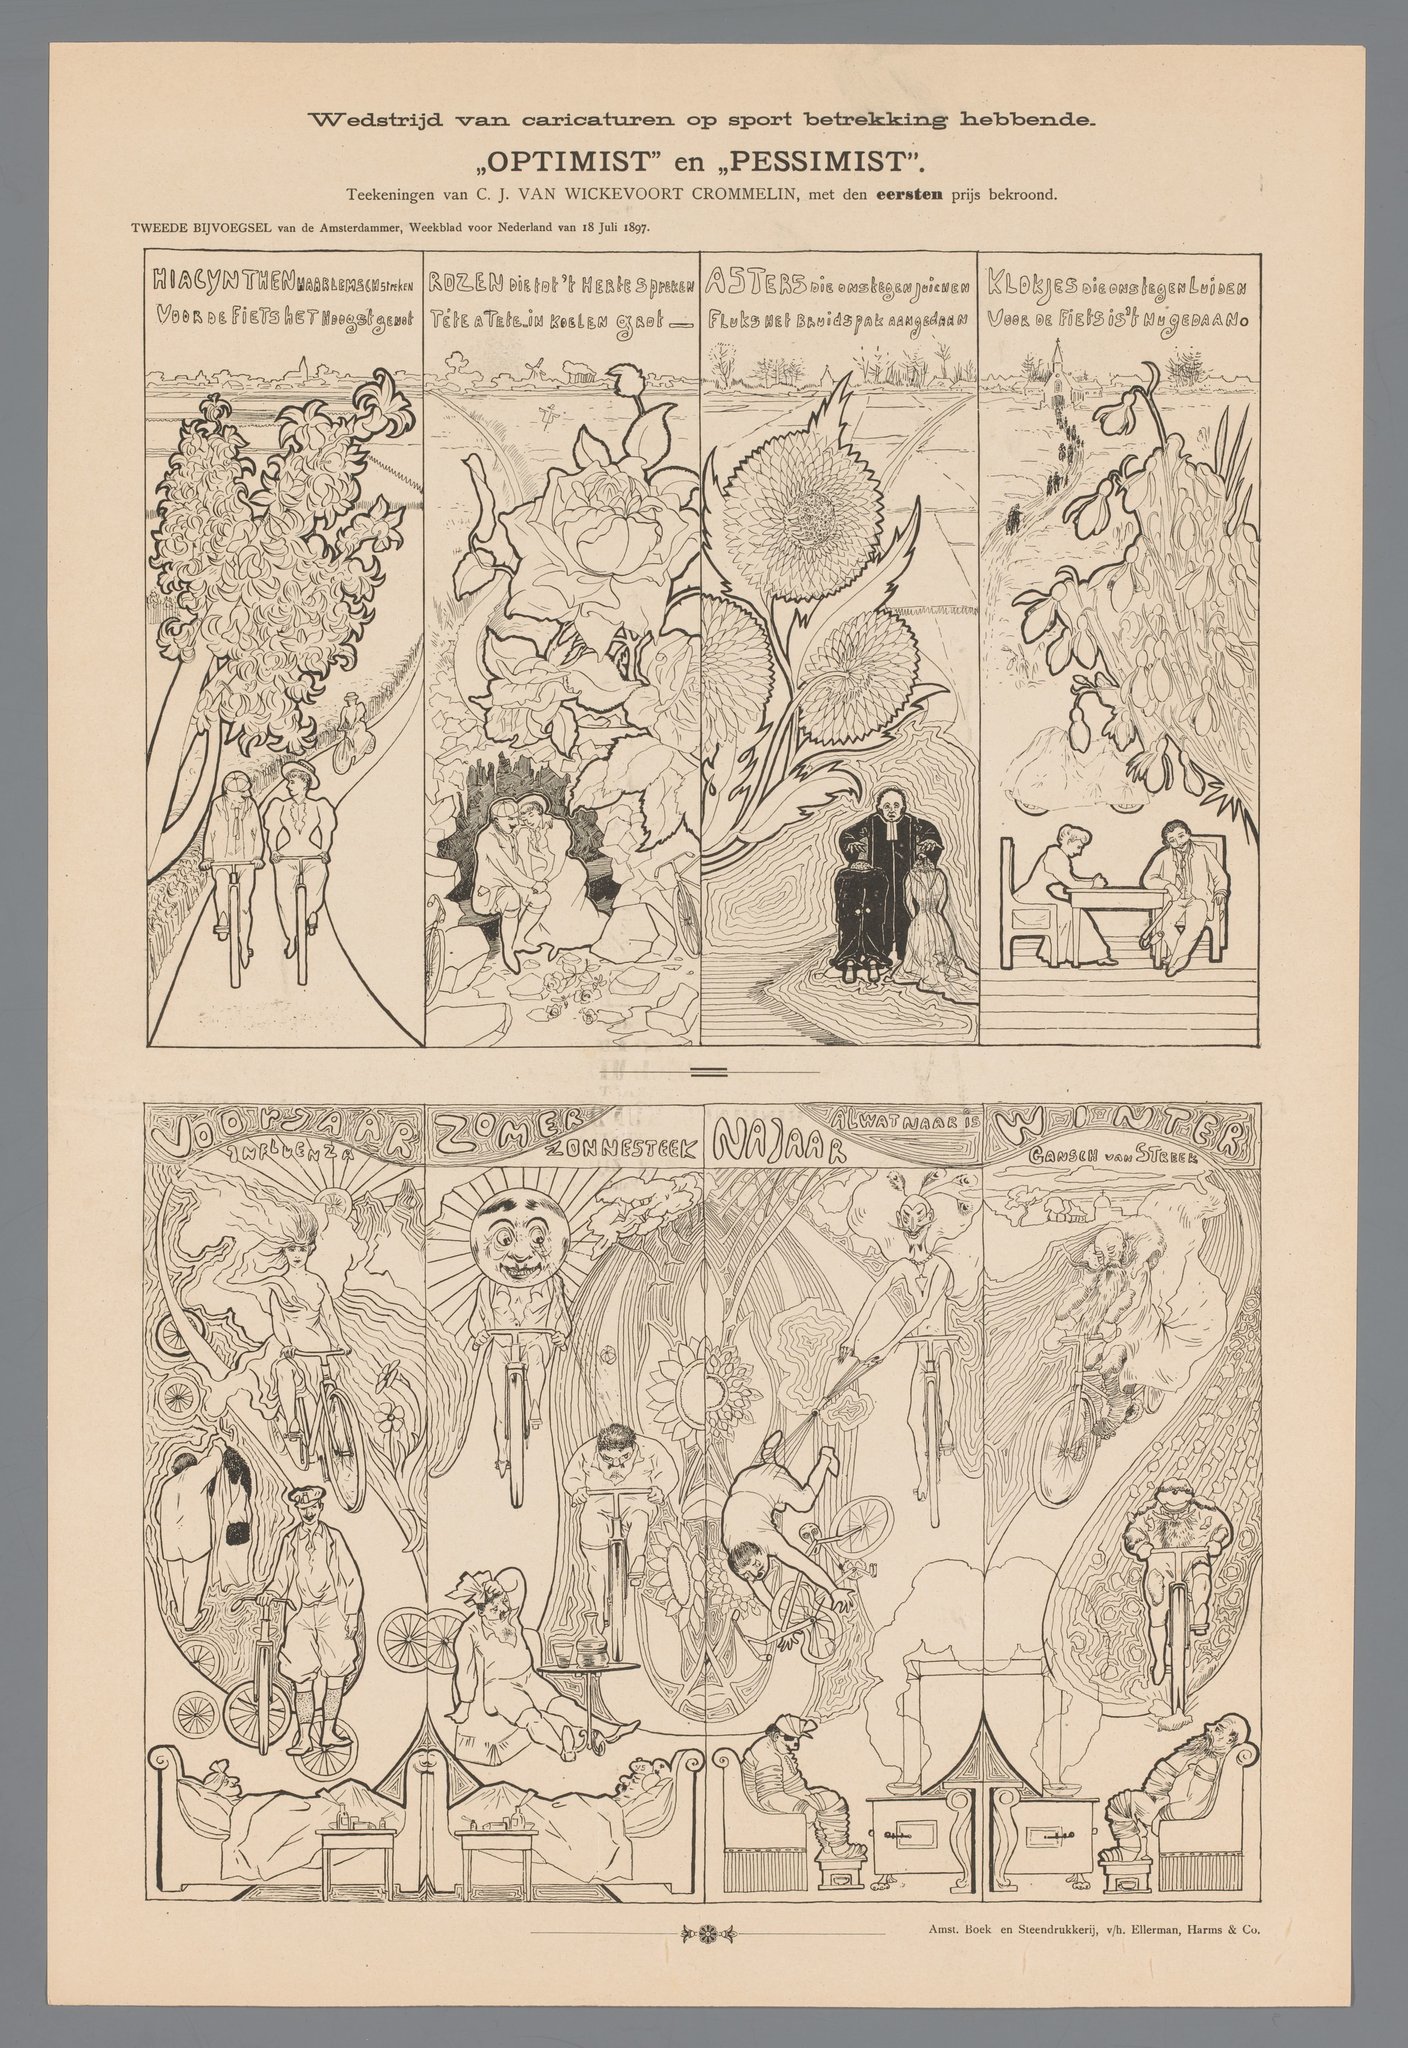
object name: cartoon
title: Wedstrijd van caricaturen op sport betrekking hebbende. "Optimist" en "Pessimist"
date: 1897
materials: paper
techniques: lithograph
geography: netherlands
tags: cornelis julius van wickevoort crommelin, flowers, pessimist, optimist, patient, sick person, the four seasons of the year ~ human activities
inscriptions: date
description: Prent uit het bijvoegsel van: De Amsterdammer. Weekblad voor Nederland, 18 juli 1897.